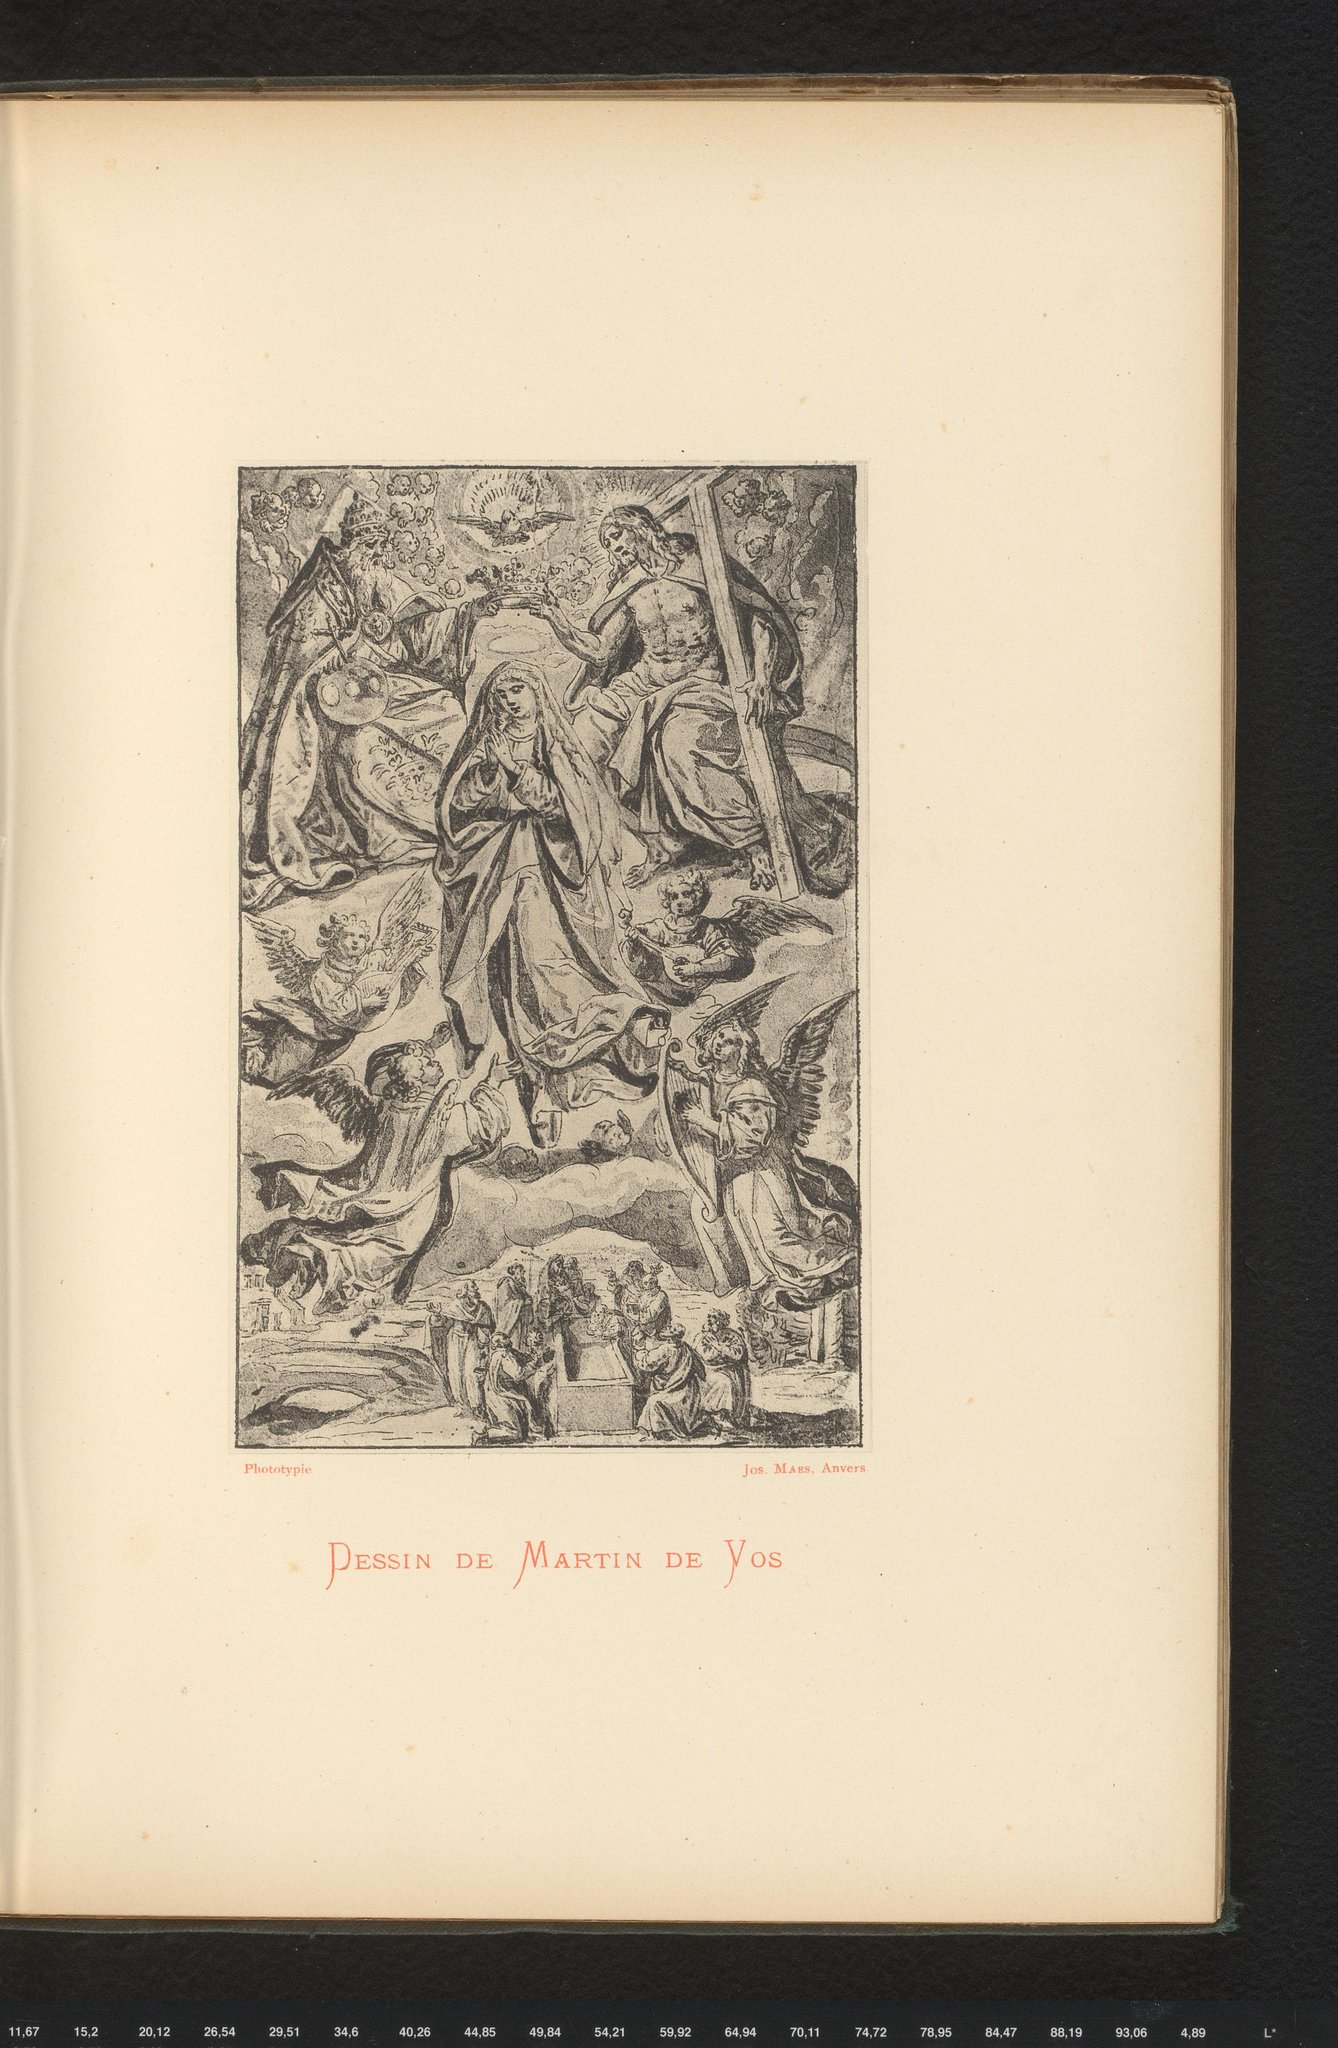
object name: page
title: Reproductie van een ontwerp van de kroning van Maria door Maerten de Vos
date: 1877-1882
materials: paper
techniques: photograph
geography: antwerp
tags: coronation of mary in heaven (usually the holy trinity present)